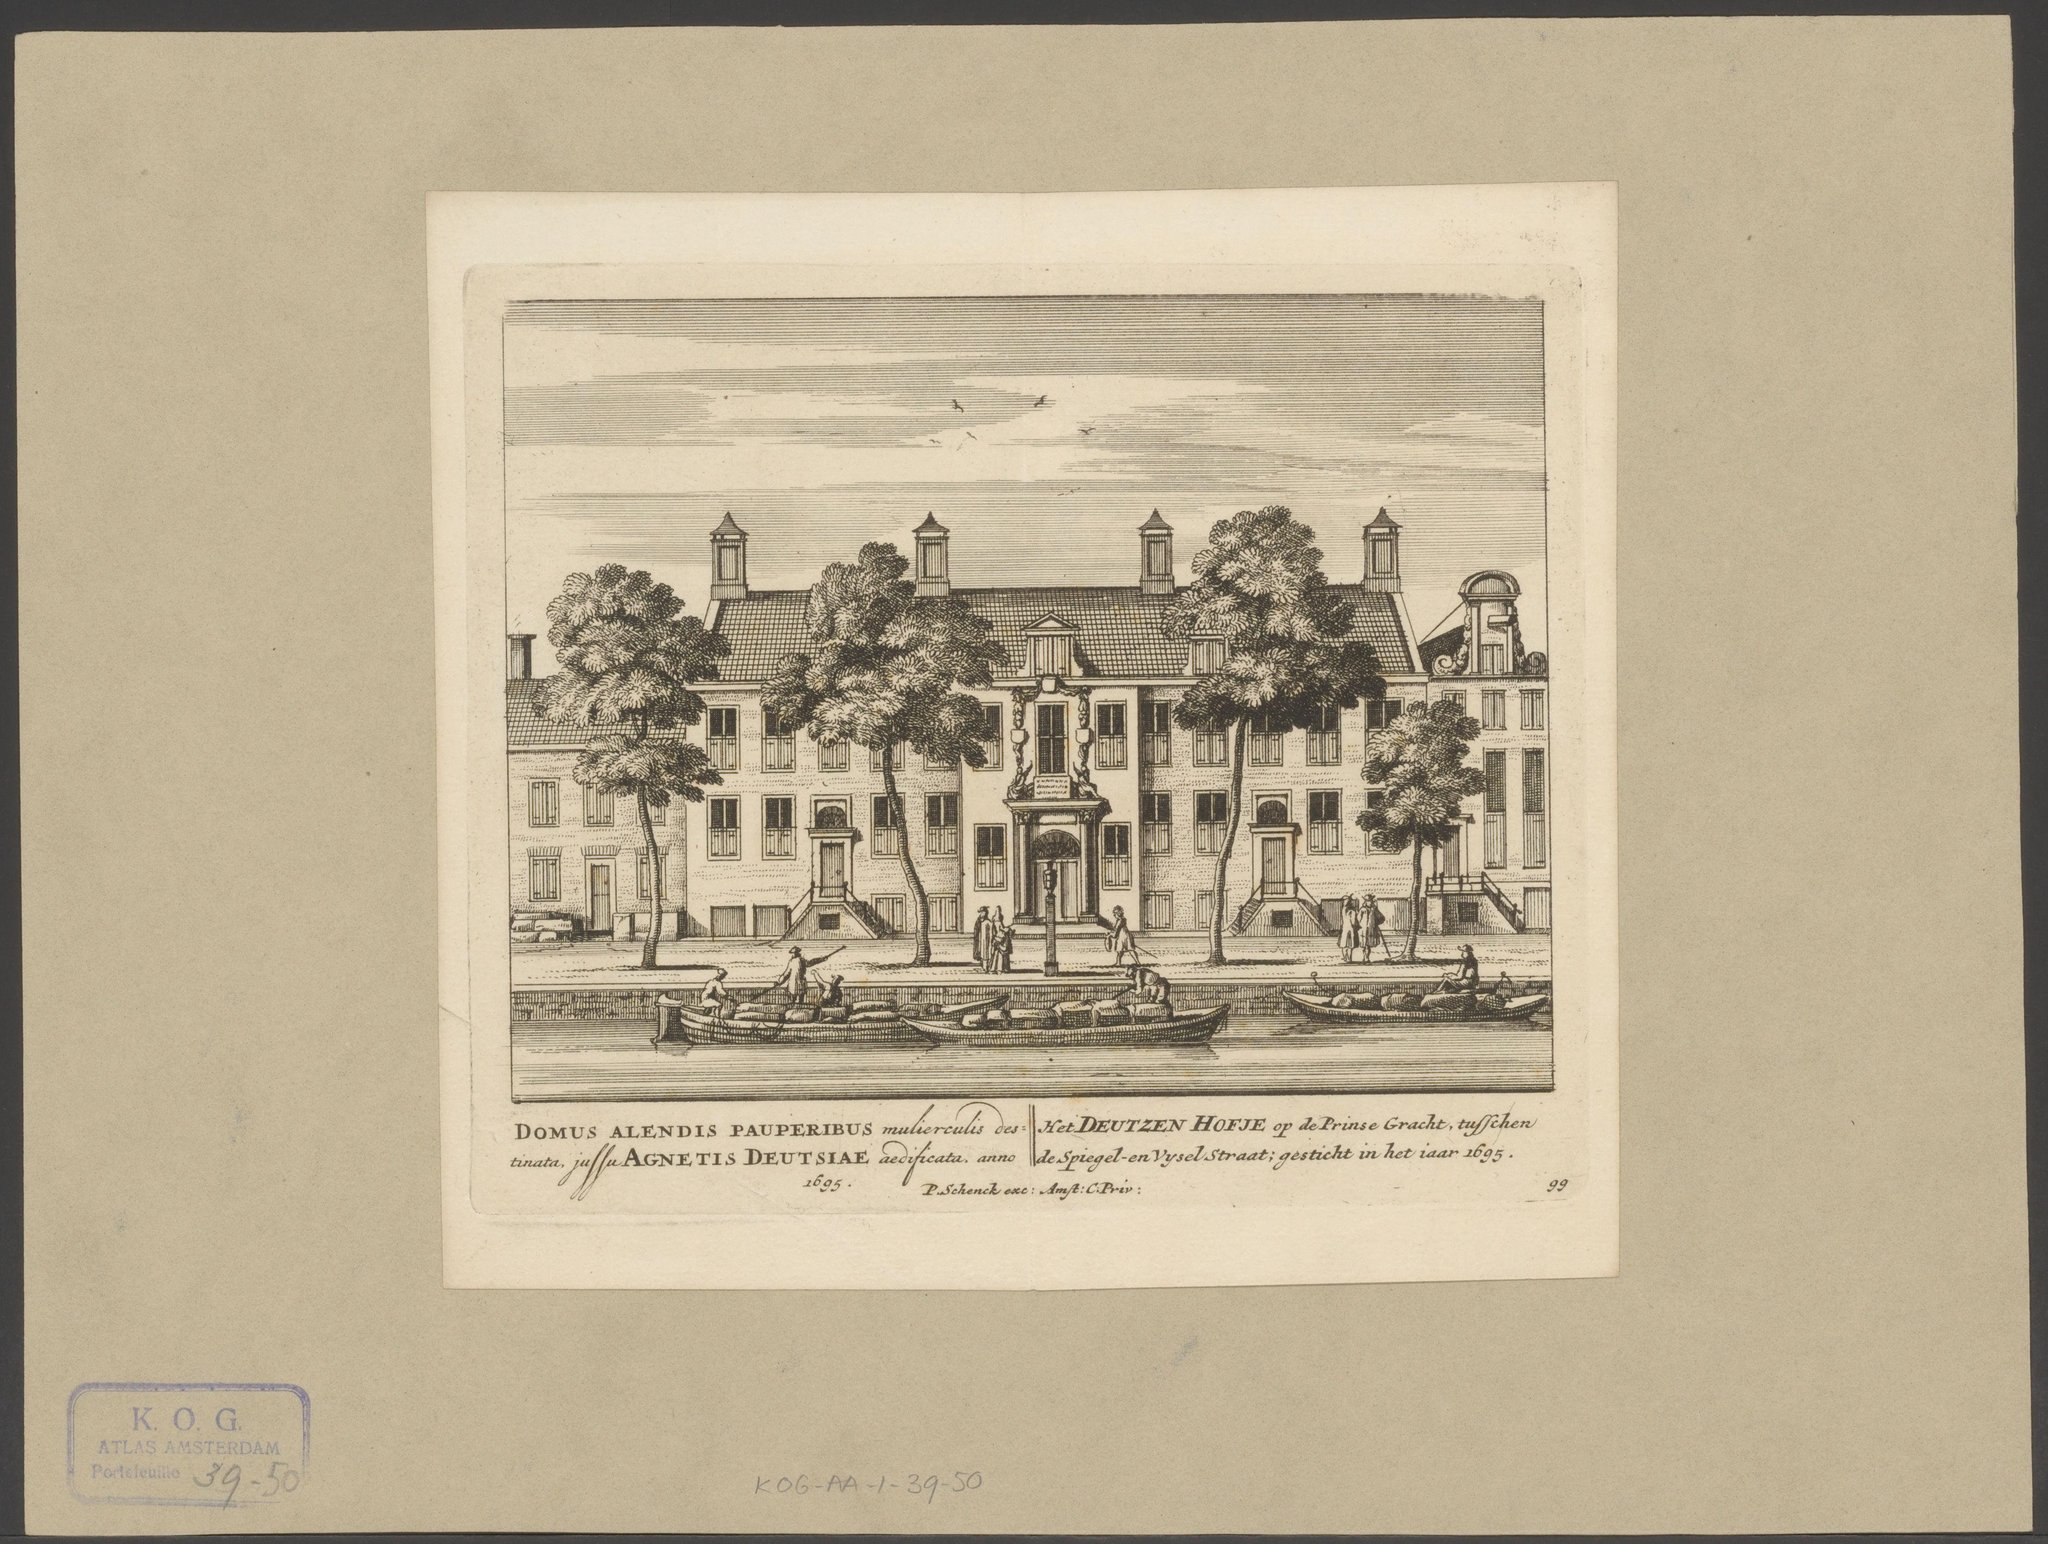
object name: print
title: Gezicht op het Deutzenhofje te Amsterdam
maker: Anonymous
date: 1710-1711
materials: paper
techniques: engraving, etching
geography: northern netherlands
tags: alms-house (dutch: 'hofje'), canals, waters (in city) (+ city(-scape) with figures, staffage)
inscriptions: collector's mark: Lugt 1641b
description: Prent mogelijk uit: 100 Afbeeldinge der voornaamste gebouwen van Amsterdam. Amsterdam: Pieter Schenk (I), s.a. [1710-1711]. Of uit: 100 Afbeeldinge der voornaamste gebouwen van Amsterdam. Amsterdam: Barent Greve, s.a. [1757-1766]. In de tweede uitgave, uitgegeven door Barent Greve, is alleen de titelprent aangepast. De overige prenten zijn onveranderd gebleven.